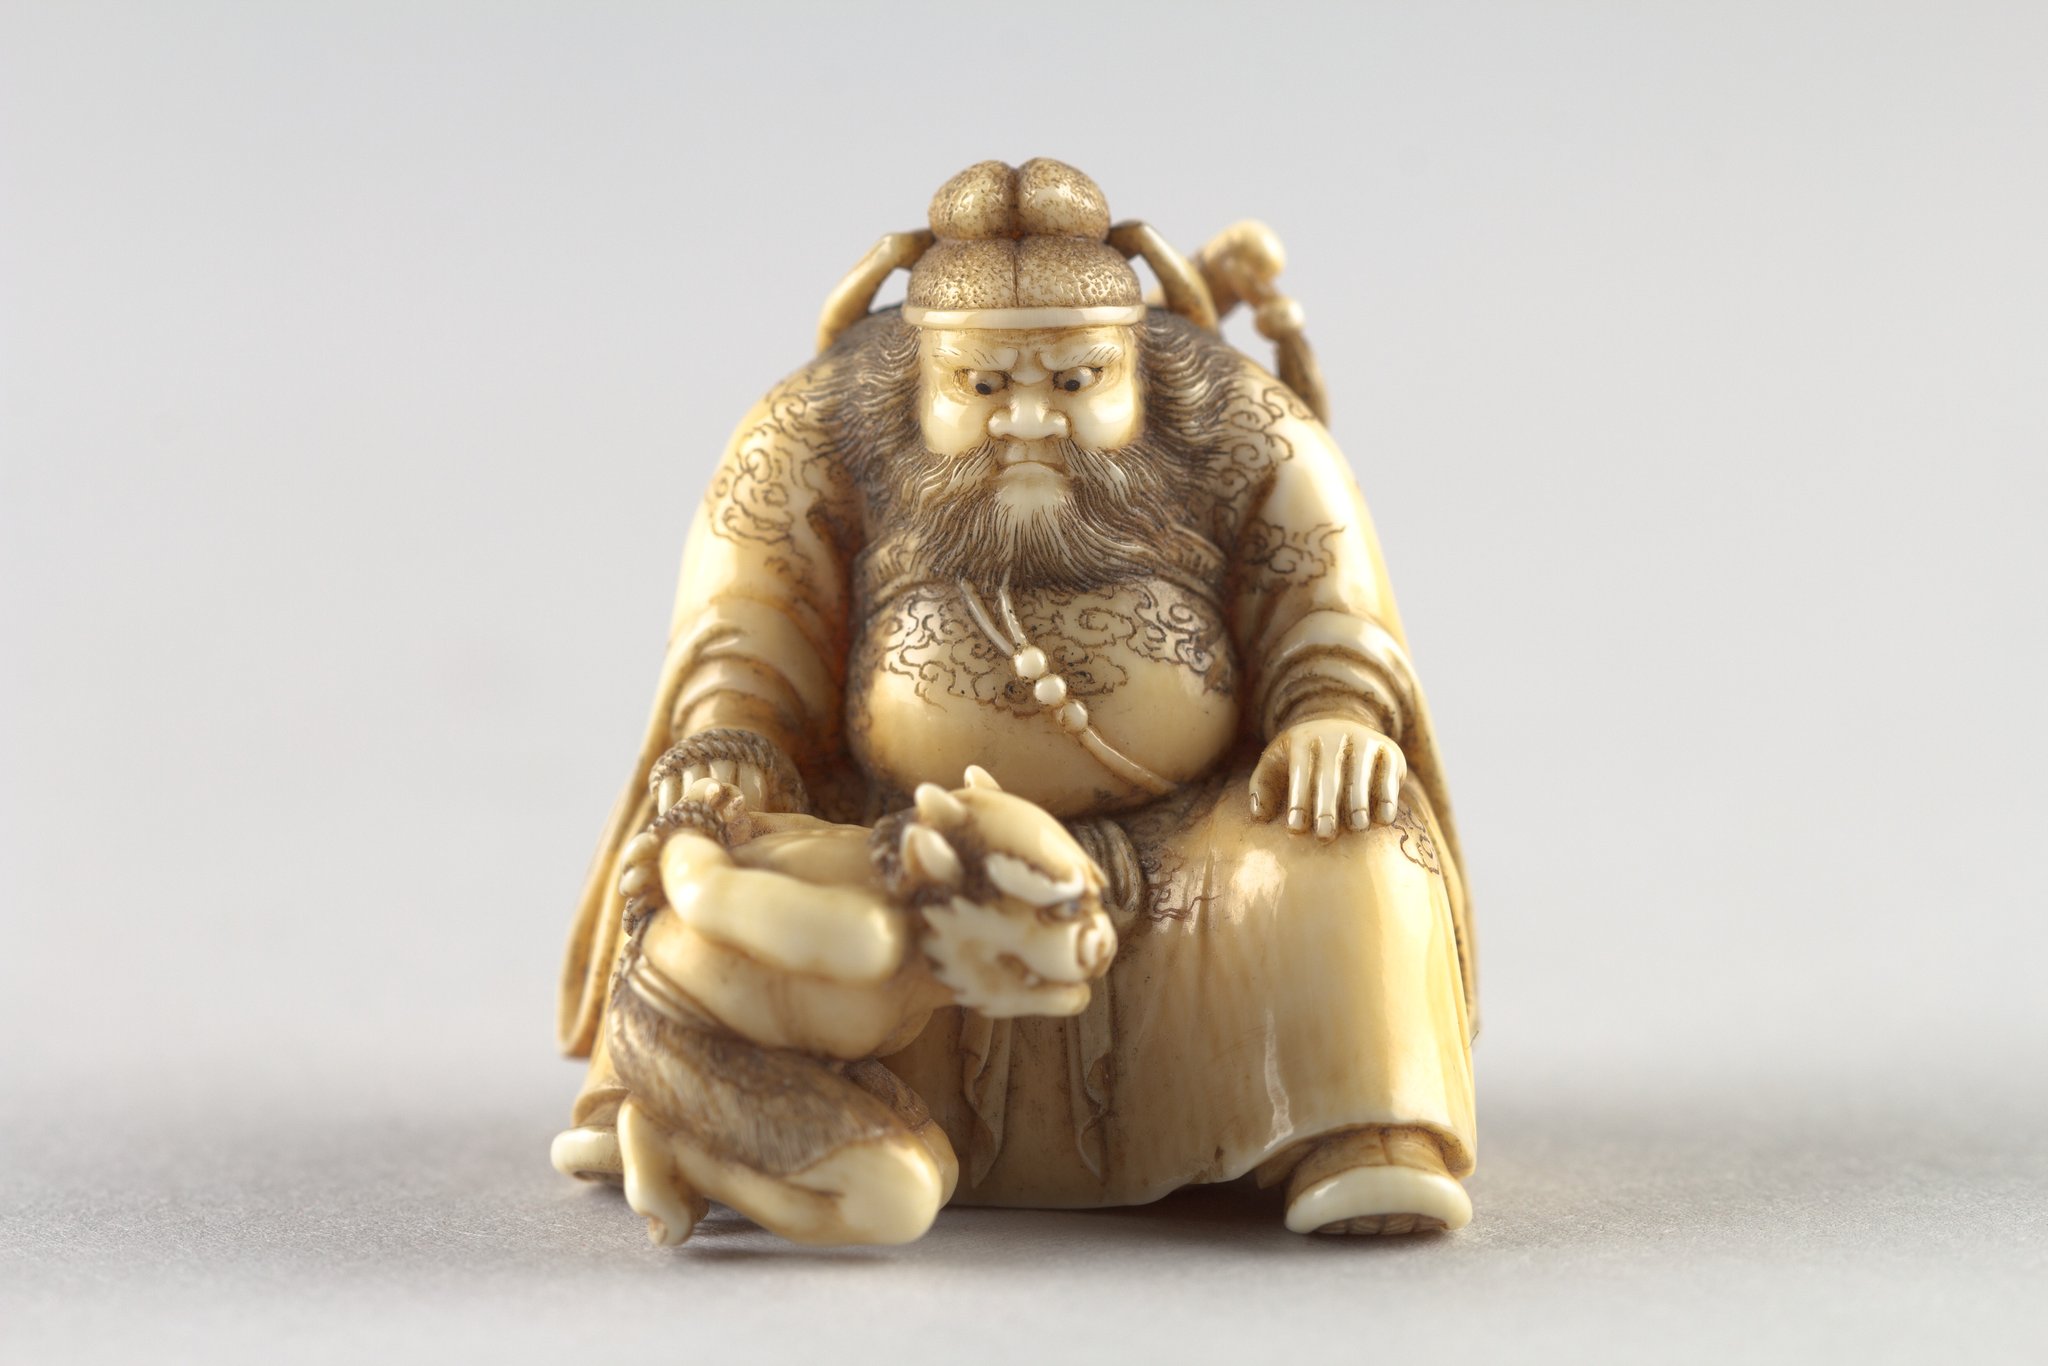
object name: netsuke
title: Netsuke of Shoki Holding a Demon by a Cord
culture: japanese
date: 1801-1900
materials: ivory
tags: men,demons